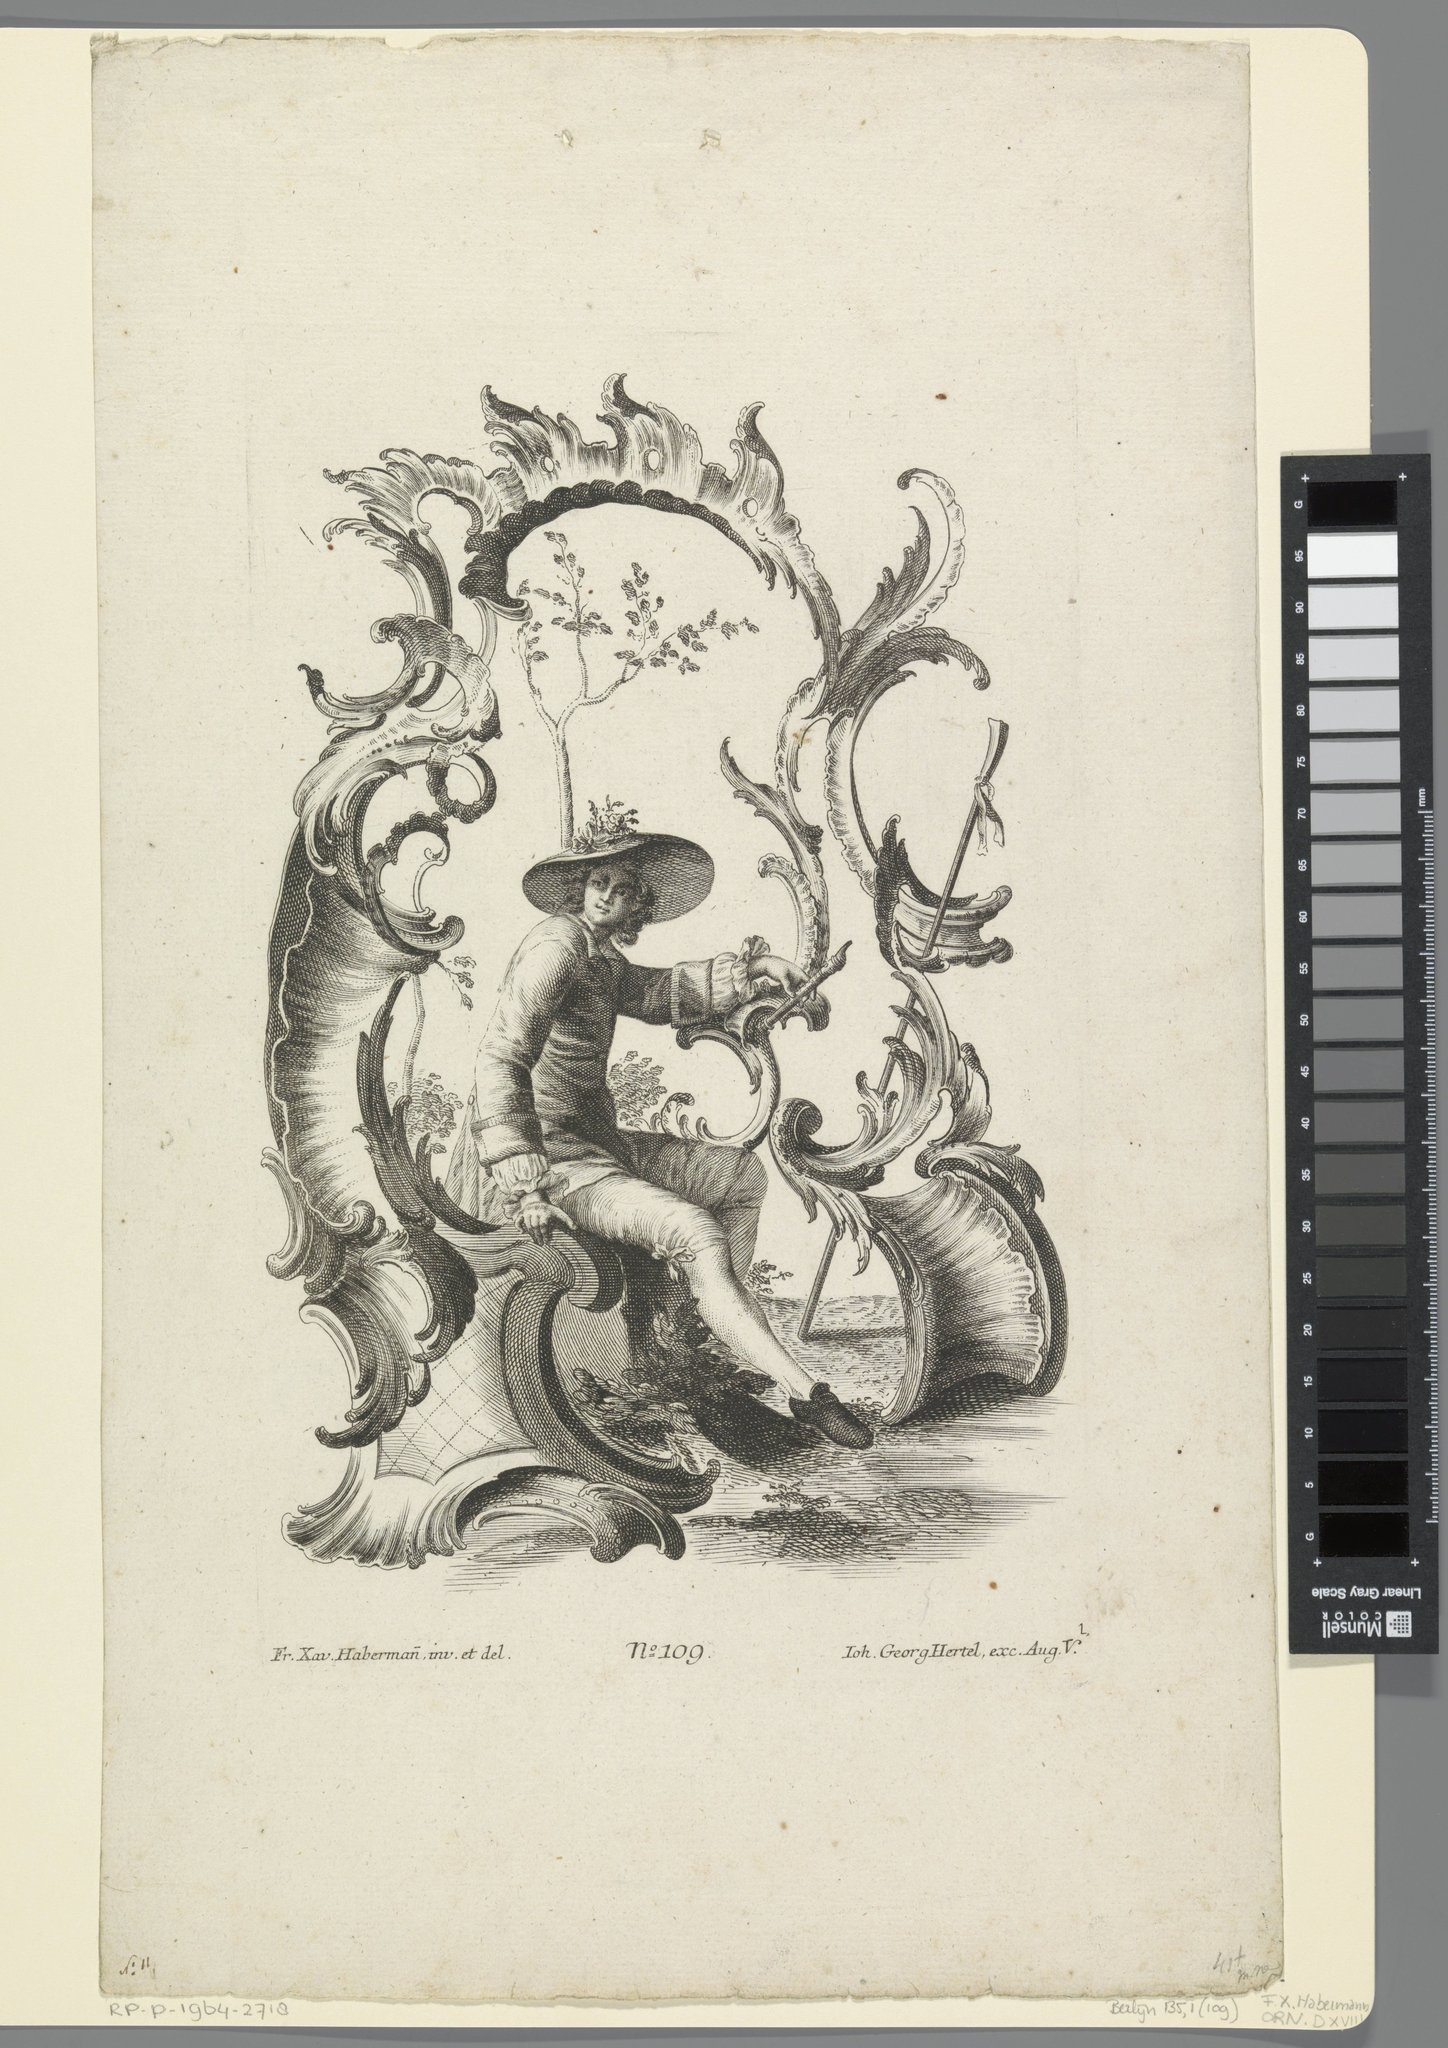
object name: print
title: Rocaille omraming met jonge man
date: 1731-1775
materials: paper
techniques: etching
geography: augsburg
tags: rocaille ornament, youth, adolescent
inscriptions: collector's mark: Lugt 2760, collector's mark: Lugt 2228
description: Rocaille omraming met jonge man met fluit, hoed en staf in landschap. Uitgeversnummer 109.